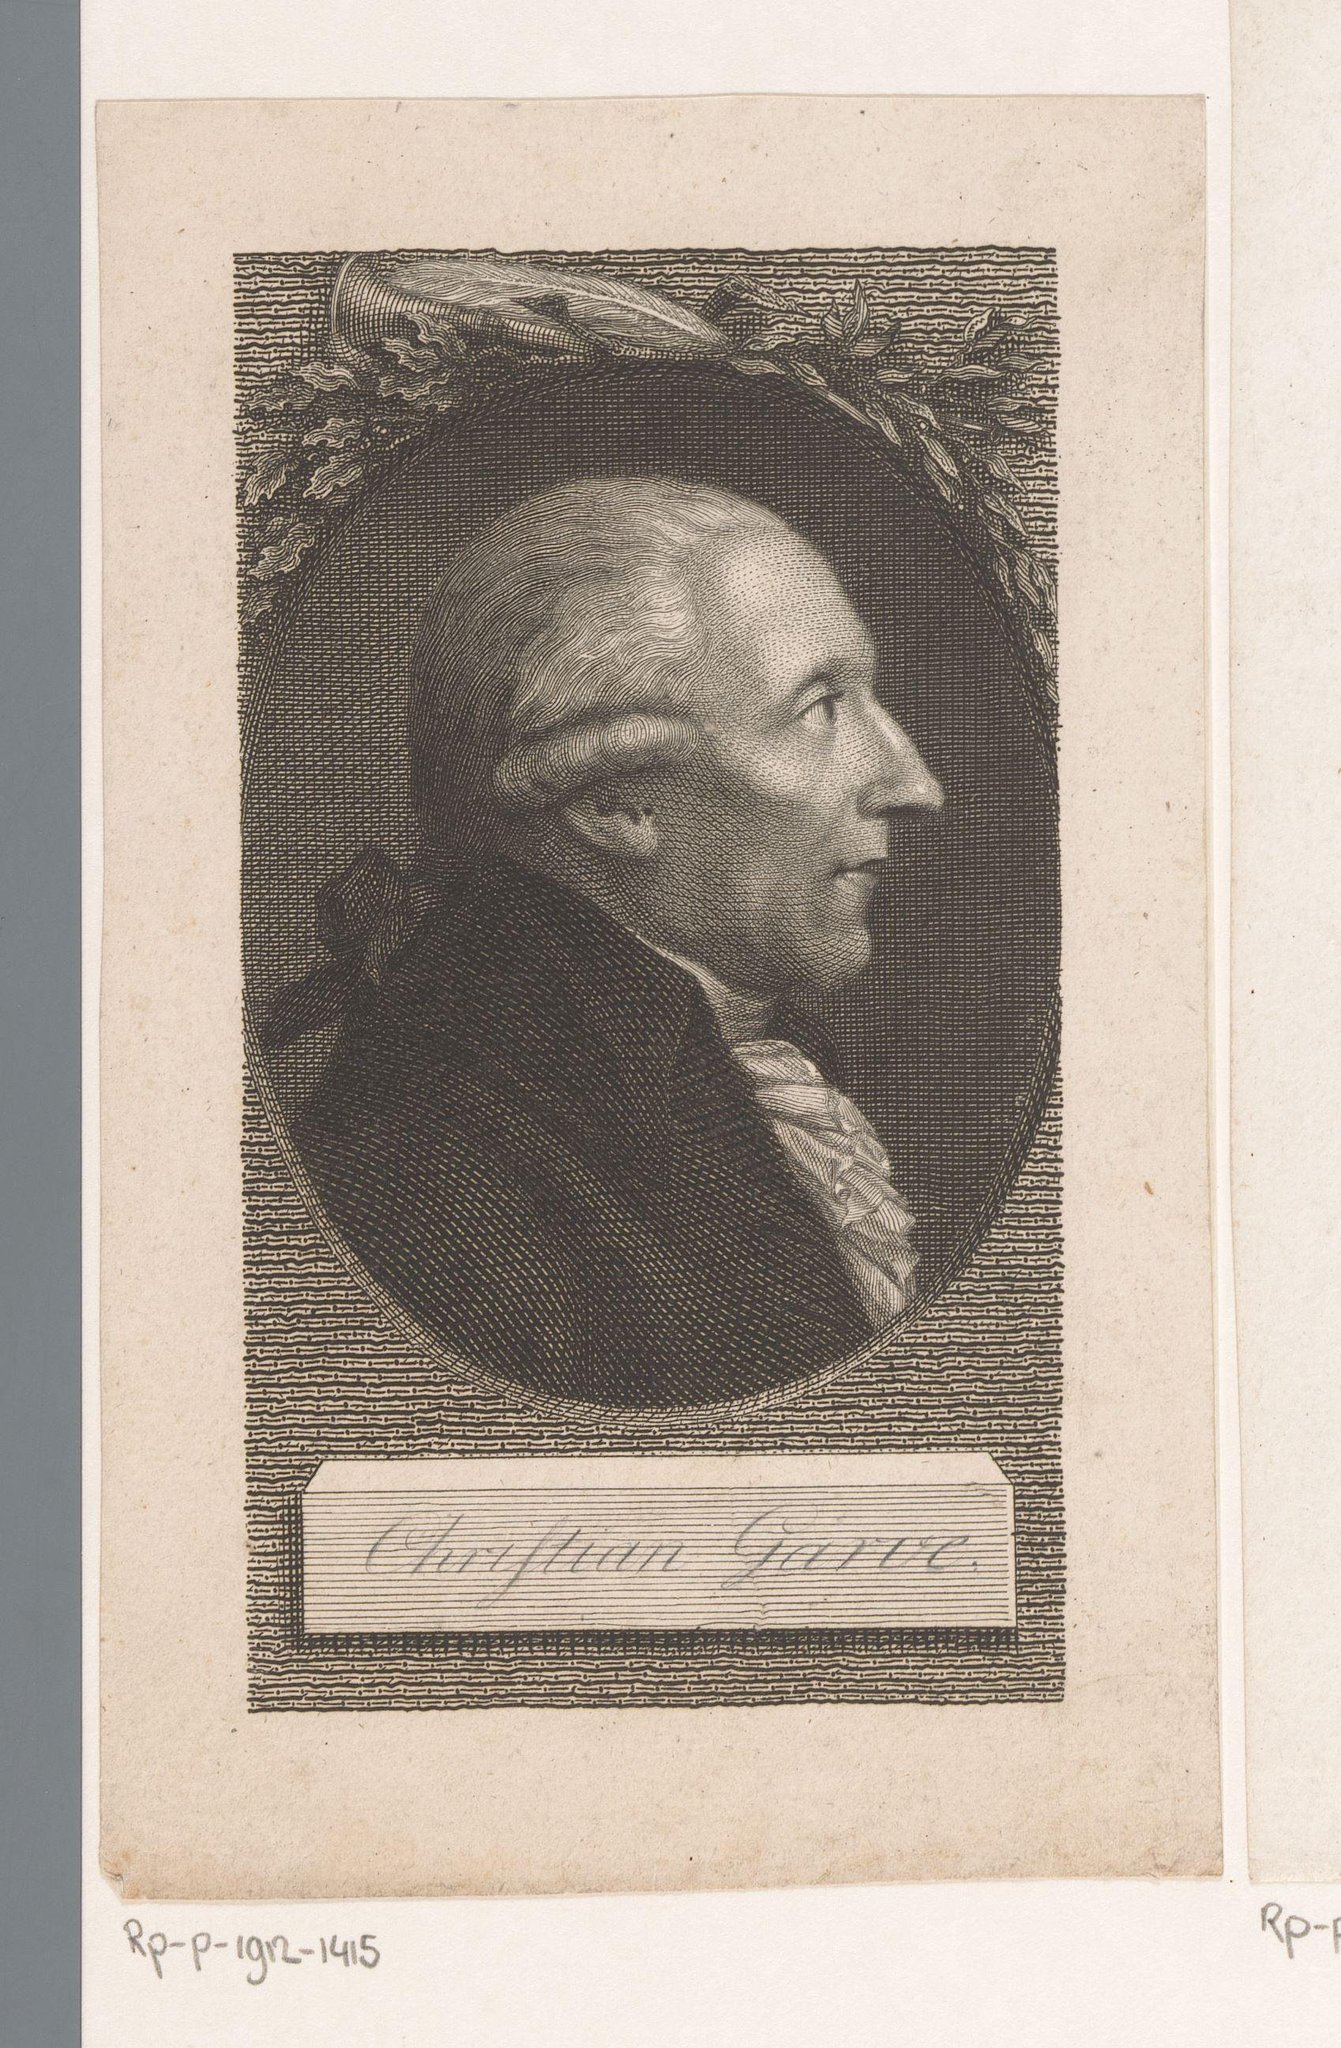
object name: print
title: Portret van Christian Garve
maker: johann christian benjamin gottschick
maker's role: print maker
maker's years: 1776-1844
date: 1786-1844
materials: paper, pencil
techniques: engraving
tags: scholar, philosopher, historical persons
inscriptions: collector's mark: Lugt 2228